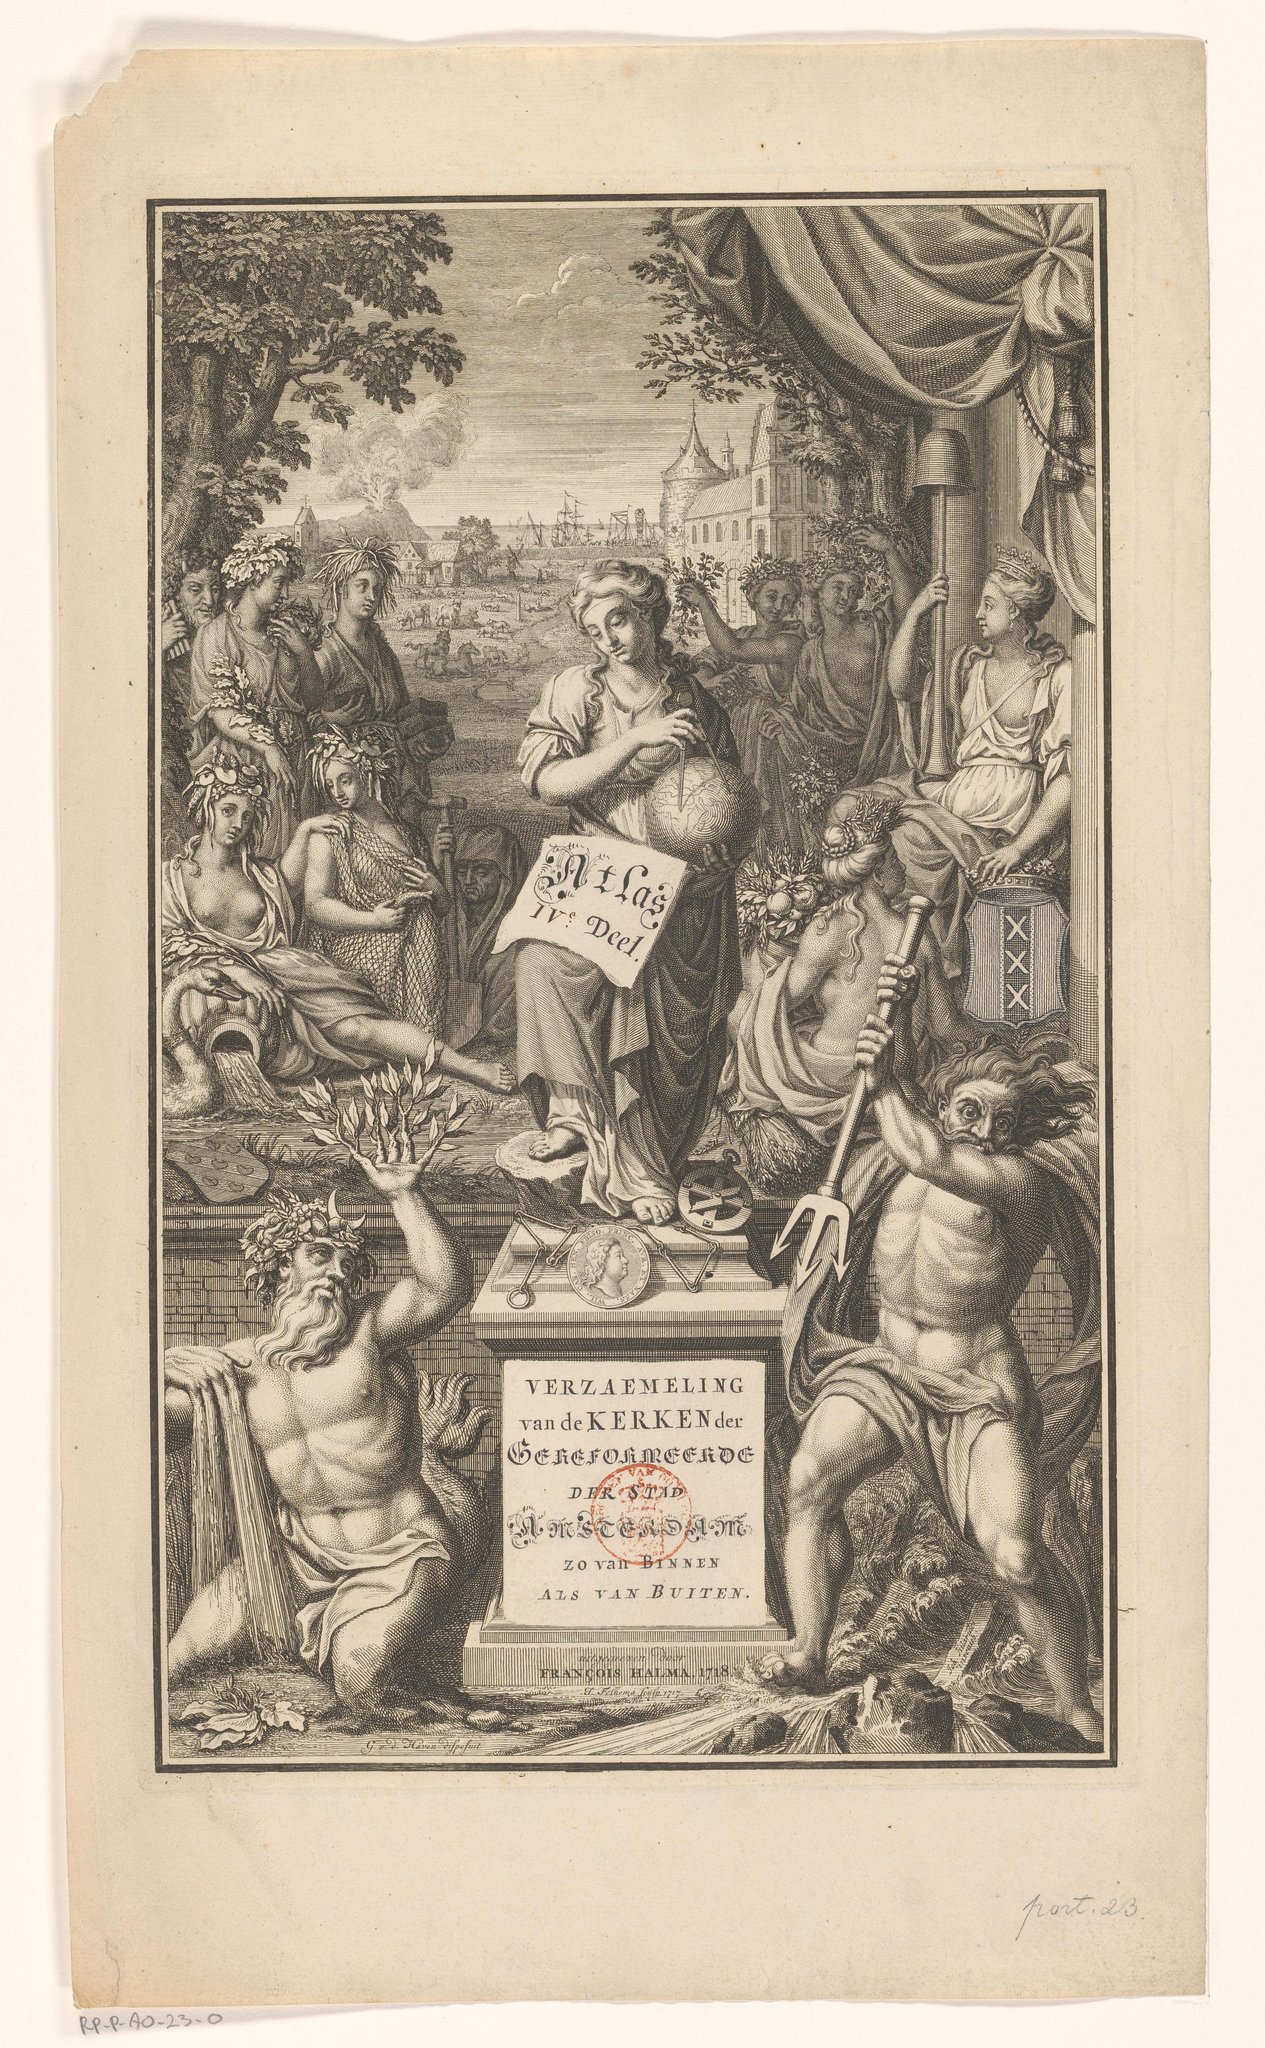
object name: titelprent, frontispice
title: Atlas IVe: Deel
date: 1717-1718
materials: ink, paper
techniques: engraving, etching, pen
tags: commercial fishery, (story of) ceres (demeter), coat of arms (as symbol of the state, etc.) (+ city; municipal), peat-cutting, 'astronomia', 'cosmografia'; 'cosmografia' (ripa), personifications of countries, nations, states, districts, etc., river-gods, 'corografia', 'geografia', 'hidrografia' (ripa), agriculture, fruitfulness, productiveness, fertility, fecundity; 'fecondità' (ripa), (story of) flora, neptune as lord of the sea, amsterdam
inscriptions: collector's mark: Lugt 19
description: Deze prent is hier gebruikt als titelprent van een deel van een ongebonden atlas; een verzameling cartografische en topografische prenten en tekeningen. Oorspronkelijk was de prent echter bedoeld als titelpagina voor een gebonden atlas met kaarten van Friesland, waardoor een deel van de hier volgende beschrijving betrekking heeft op die context. Op het voetstuk in het midden staat de personificatie van de cartografie, met in haar hand een aardbol die ze met een passer meet. Op haar bovenbeen rust een blad met het handgeschreven deel van de atlas (oorspronkelijk een kaart van Friesland). Aan haar voeten een meetketting, een rond (land)meetkundig instrument en een portret van Willem IV van Oranje-Nassau. Daaronder de handgeschreven titel van dit deel van de atlas. Ze houdt een wakend oog op Wispelturigheid (Wispeltuer), linksonder. Oorspronkelijk staat hij voor de wispelturigheid waar het Friese land zich naar moest schikken: een bos kon opeens onder water staan, want zijn lichaam smelt door het zoute water van de zee. Linksboven zijn hoofd een wapenschild met het wapen van Friesland (met schuinbalken en pompeblêden). De dreiging van de zee is rechtsonder verbeeld door een onstuimige Neptunus (Zeevoogd). Links en rechts van Cartografie nog meer figuren die oorspronkelijk betrekking hadden op Friesland en haar vruchtbare natuur, visserij en landbouw. Links, met haar arm leunend op een kruik waar water uitstroomt, een stroomgodin (Stroomvoogdess) met rechts van haar de personificatie van de visserij (Visschevang). Boven hen van links naar rechts: een sater met fluit als personificatie van de natuur (Natuer), de personificatie van de bossen met eikenloven (Woudman) en personificatie van de turfwinning (vrouw Veenbrand). Rechtsonder haar vrouw Onland, die rouwt om de schade die de turfwinning aan het land veroorzaakt. Rechts van Cartografie zit Flora en/of Ceres (vrouw Veldgewas) met korenaren en cornucopia, ze staat voor de overvloed die voortvloeit uit het land. Boven haar, op de achtergrond, twee vrouwelijke personificaties die in verband staan met groene weides en/of grasvelden: Beemdeheil en Graazevol. Rechts, met in haar ene hand een bazuin met daarop een vrijheidshoed en in de andere hand een schild met het wapen van Amsterdam, de personificatie van het gebied van dit deel van de atlas (oorspronkelijk de Friese Maagd met het provinciewapen met twee leeuwen). Op de achtergrond een landschap met kenmerkende Friese elementen, zoals het Sjaerdemaslot te Franeker en de vuurspuwende Rode Klif te Gaasterland (zou in de oudheid een vulkaan zijn geweest).